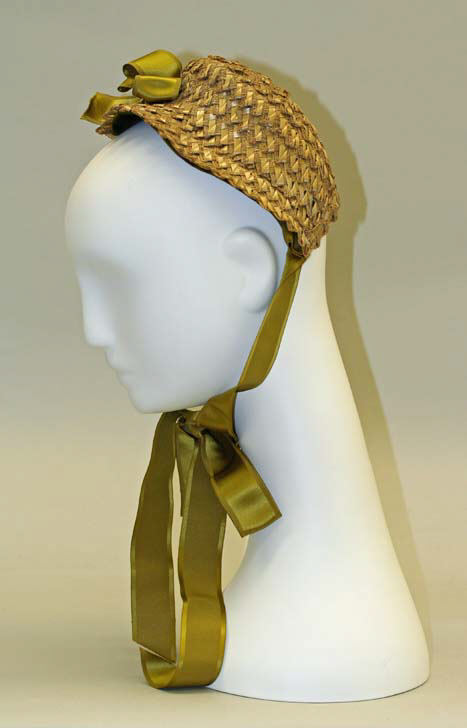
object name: bonnet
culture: american or european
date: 1880-1889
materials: silk, fiber